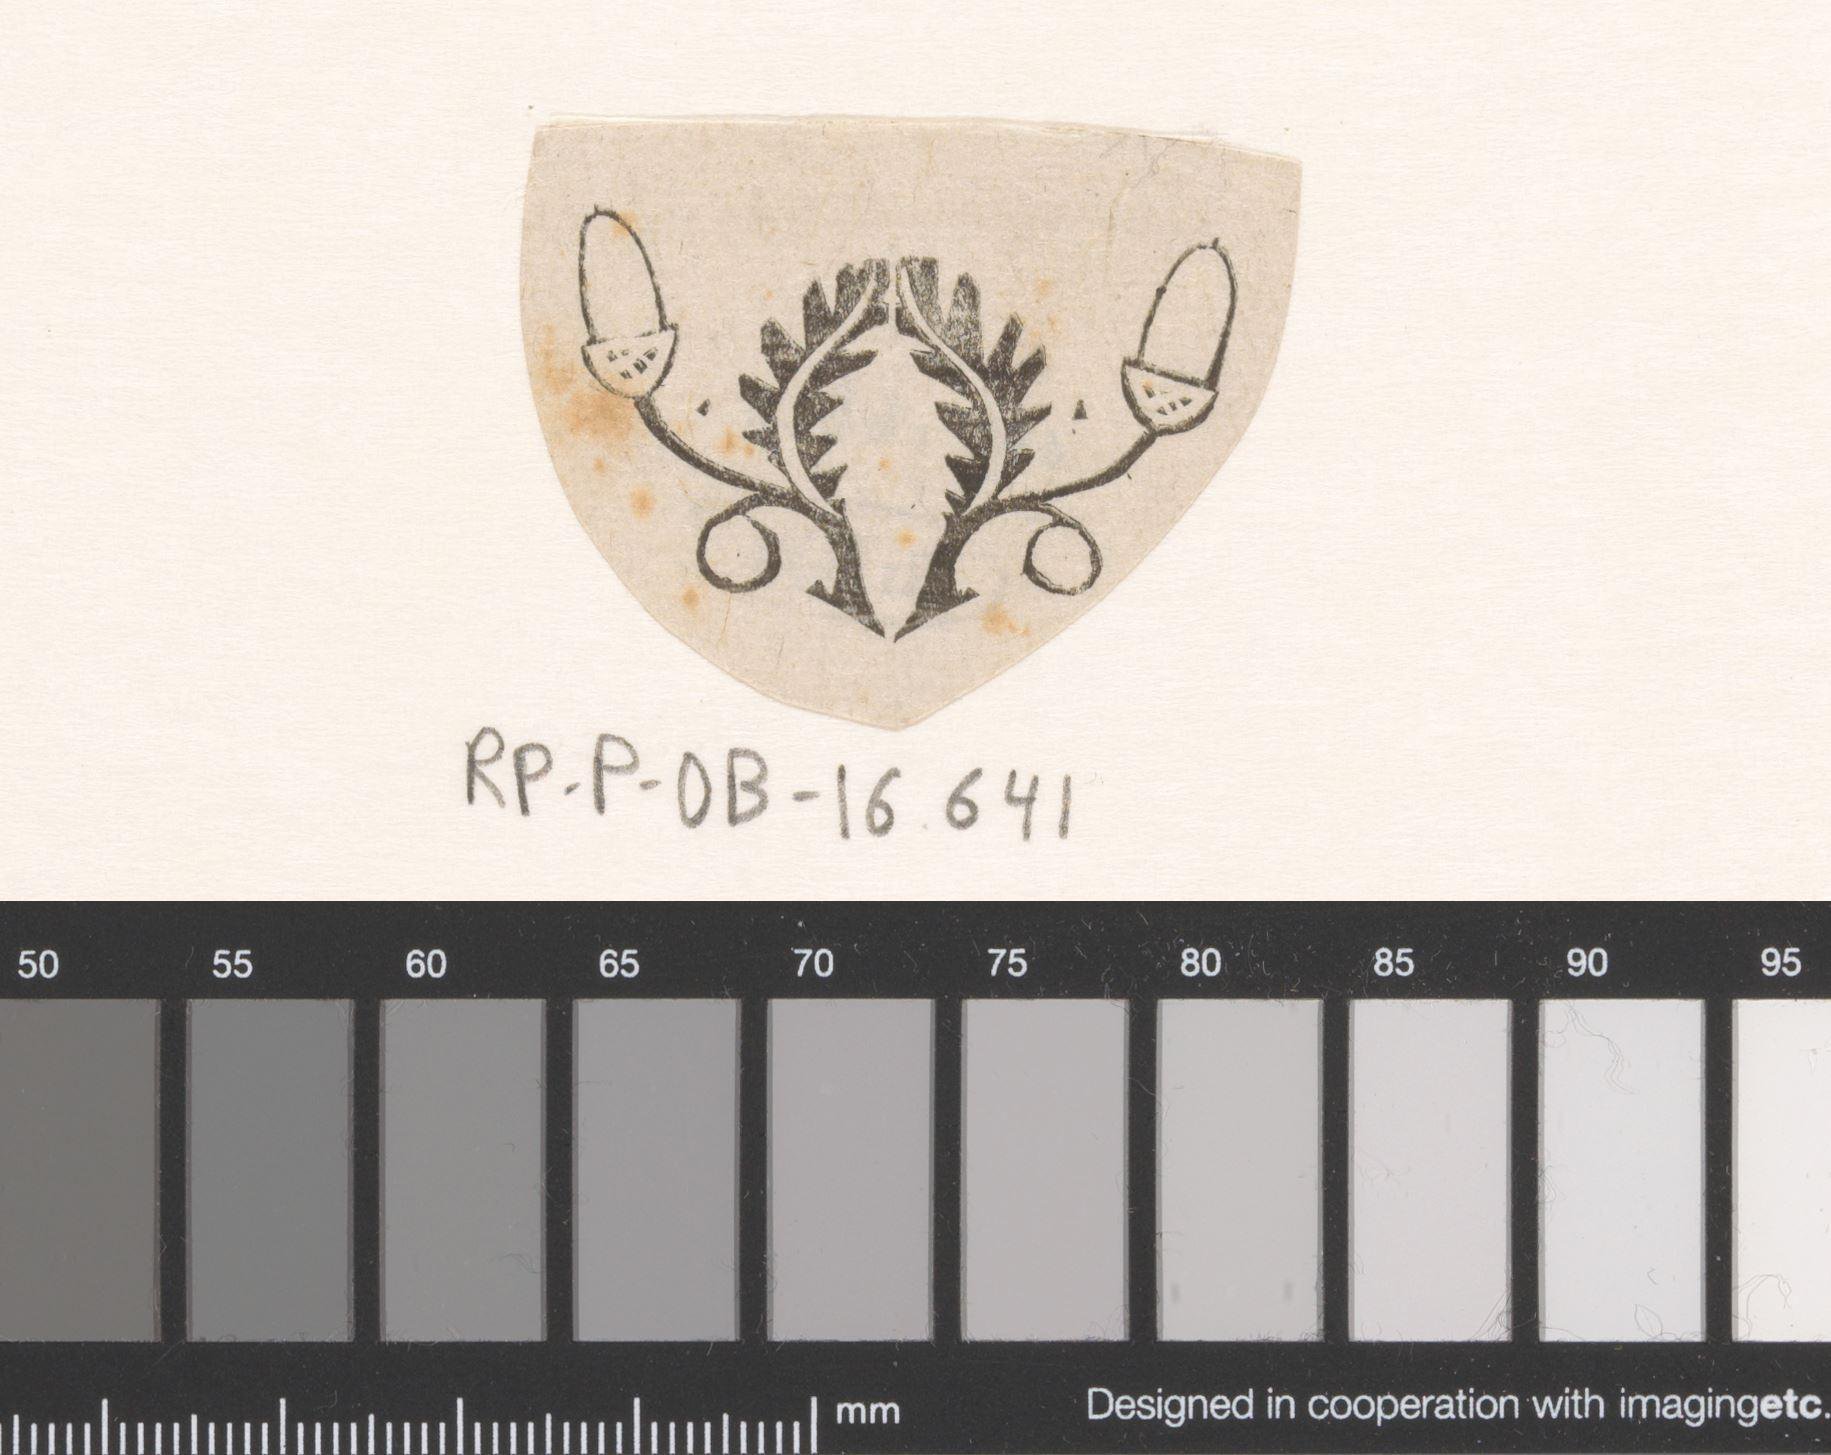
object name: print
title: Vignet met eikels en eikenblad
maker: gerrit willem dijsselhof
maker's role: designer, draughtsman, print maker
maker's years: 1866-1924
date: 1876-1924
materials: paper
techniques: woodcut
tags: trees: oak (+ leaf), fruits: acorn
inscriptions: collector's mark: Lugt 2228